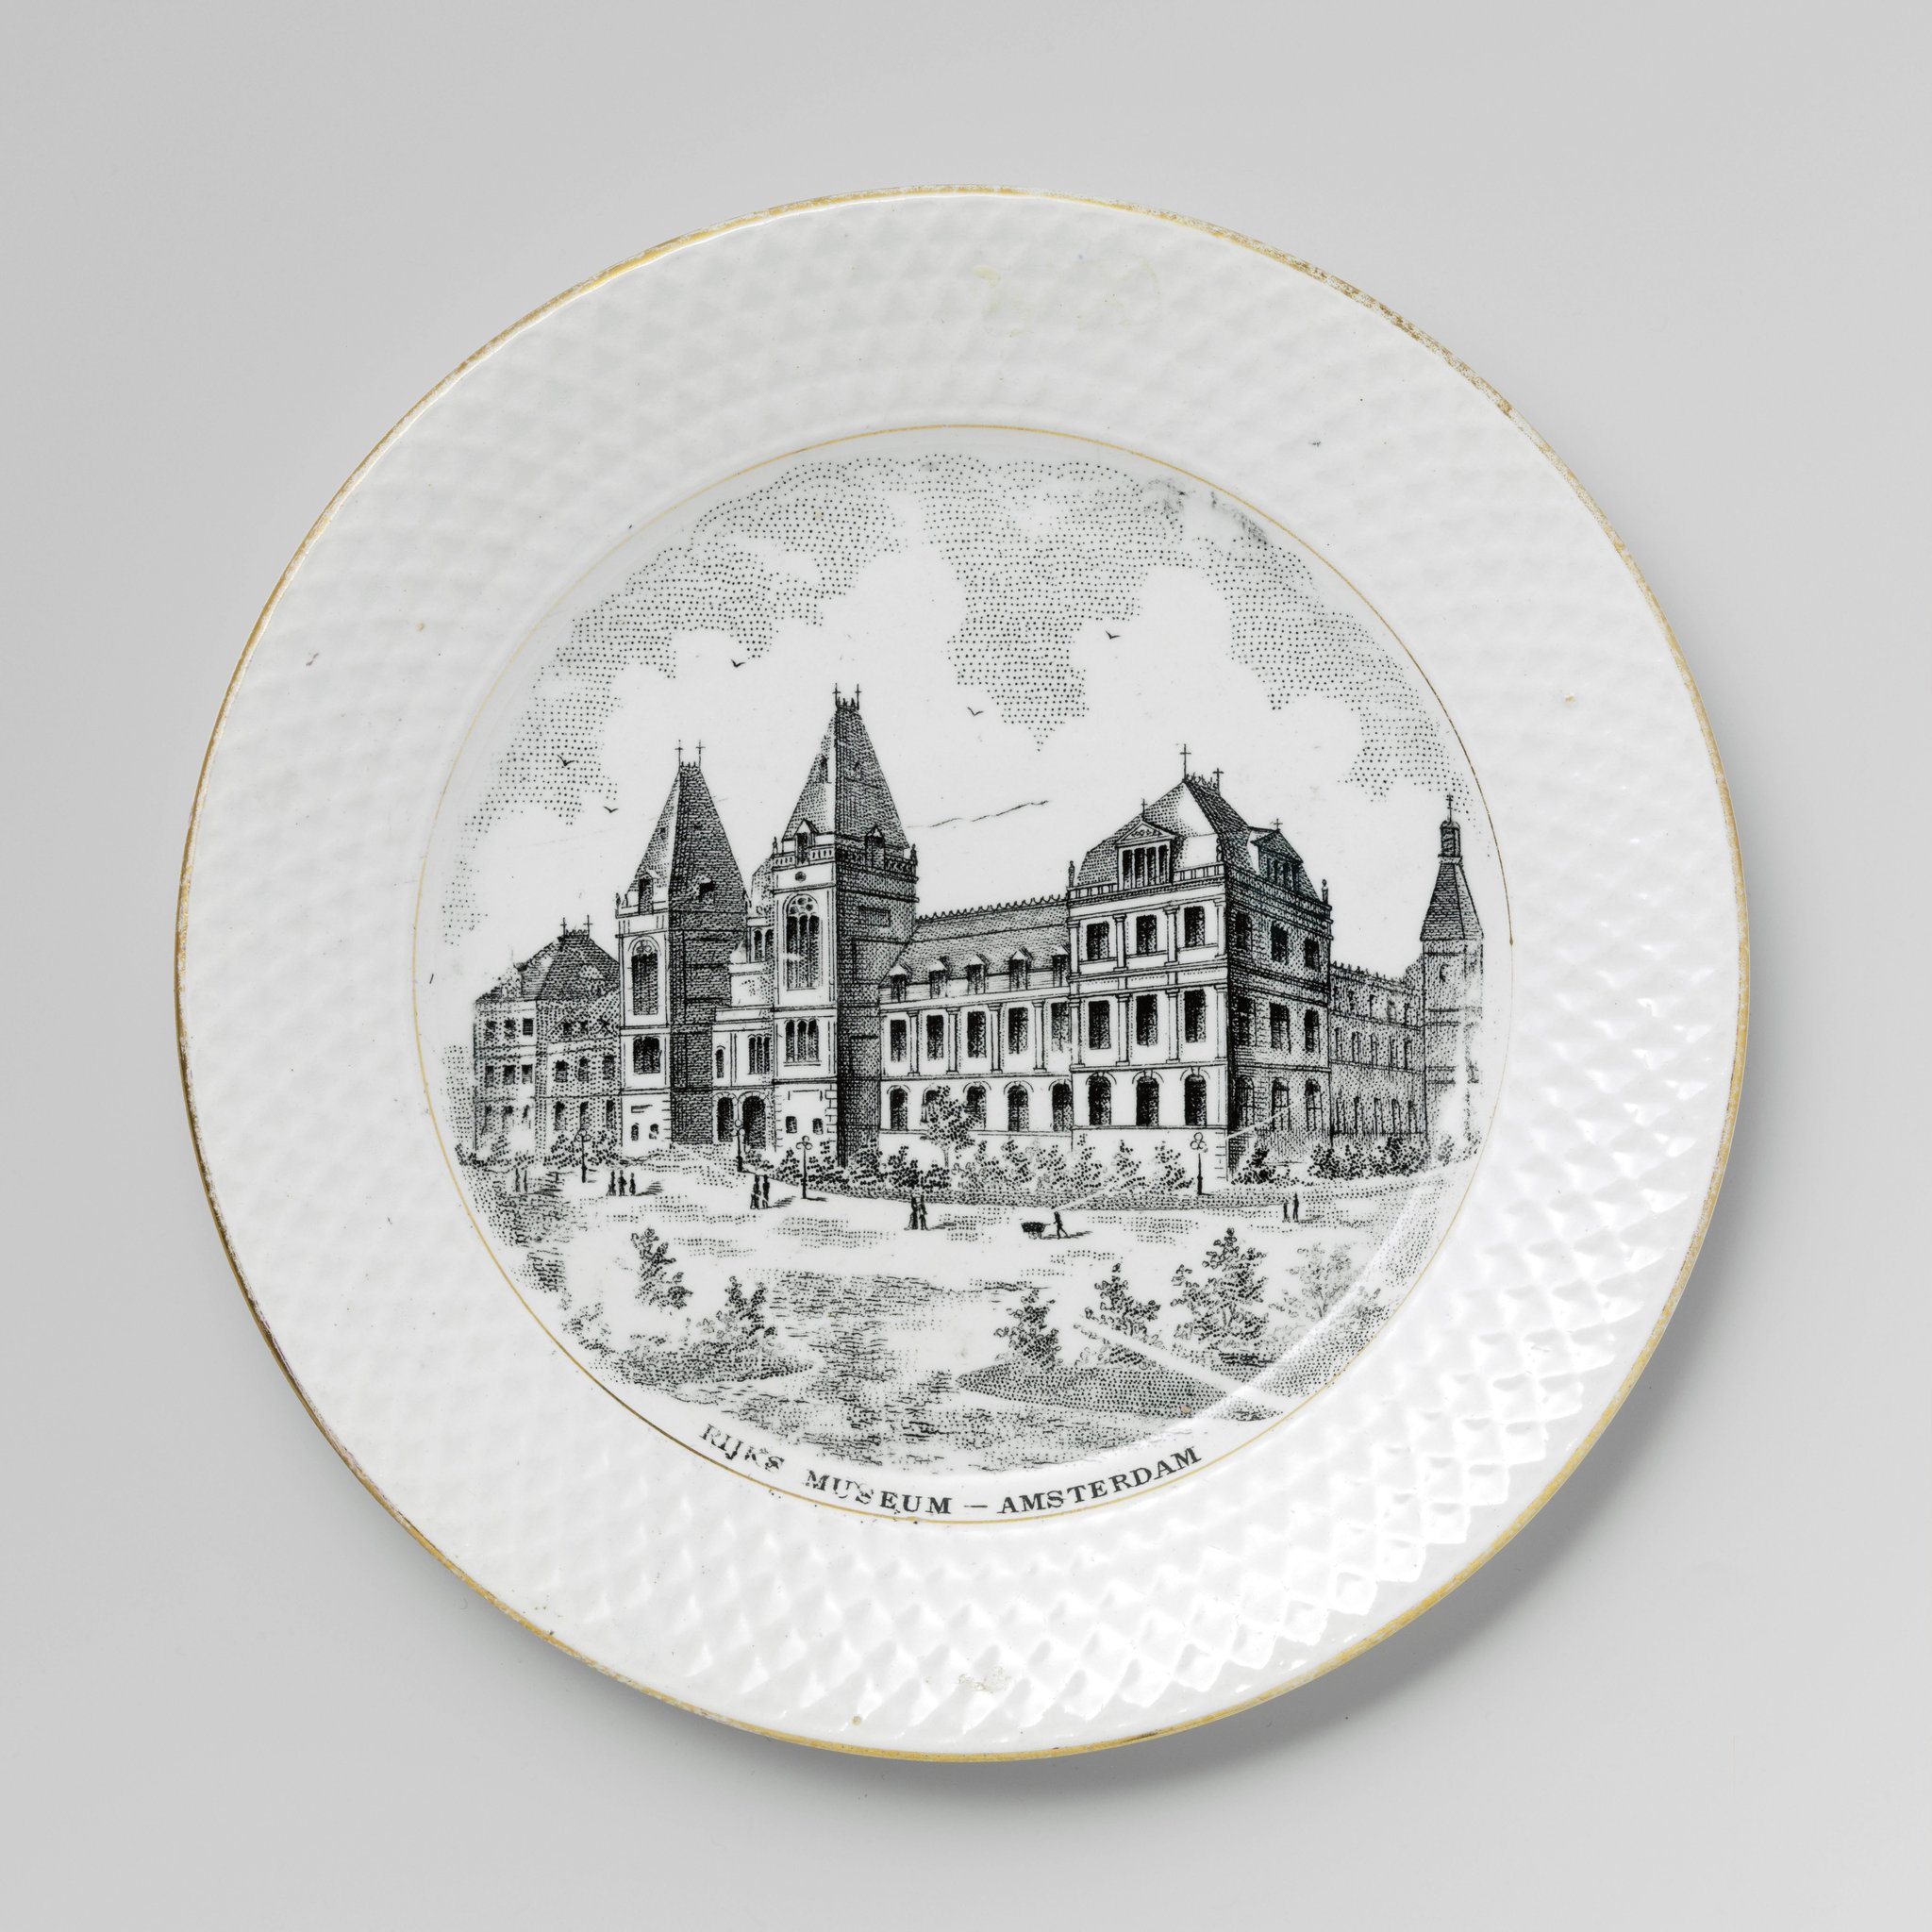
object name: plate dish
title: Bord met op het plat het Rijks Museum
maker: petrus regout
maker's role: plateelbakker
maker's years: 1801-1879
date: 1893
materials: earthenware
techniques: transfer decoration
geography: maastricht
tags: rijksmuseum amsterdam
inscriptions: stamp: ‘sfinx // PETRUS REGOUT & Co // MAASTRICHT // MONUMENTEN // MADE IN HOLLAND’, inscription: ‘RIJKS MUSEUM - AMSTERDAM’, : ‘AW 6 (of 9)’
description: Bord van aardewerk met op het plat in zwart transferdecor een voorstelling van het Rijks Museum. De rand met kruisbrodé en gouden filets.